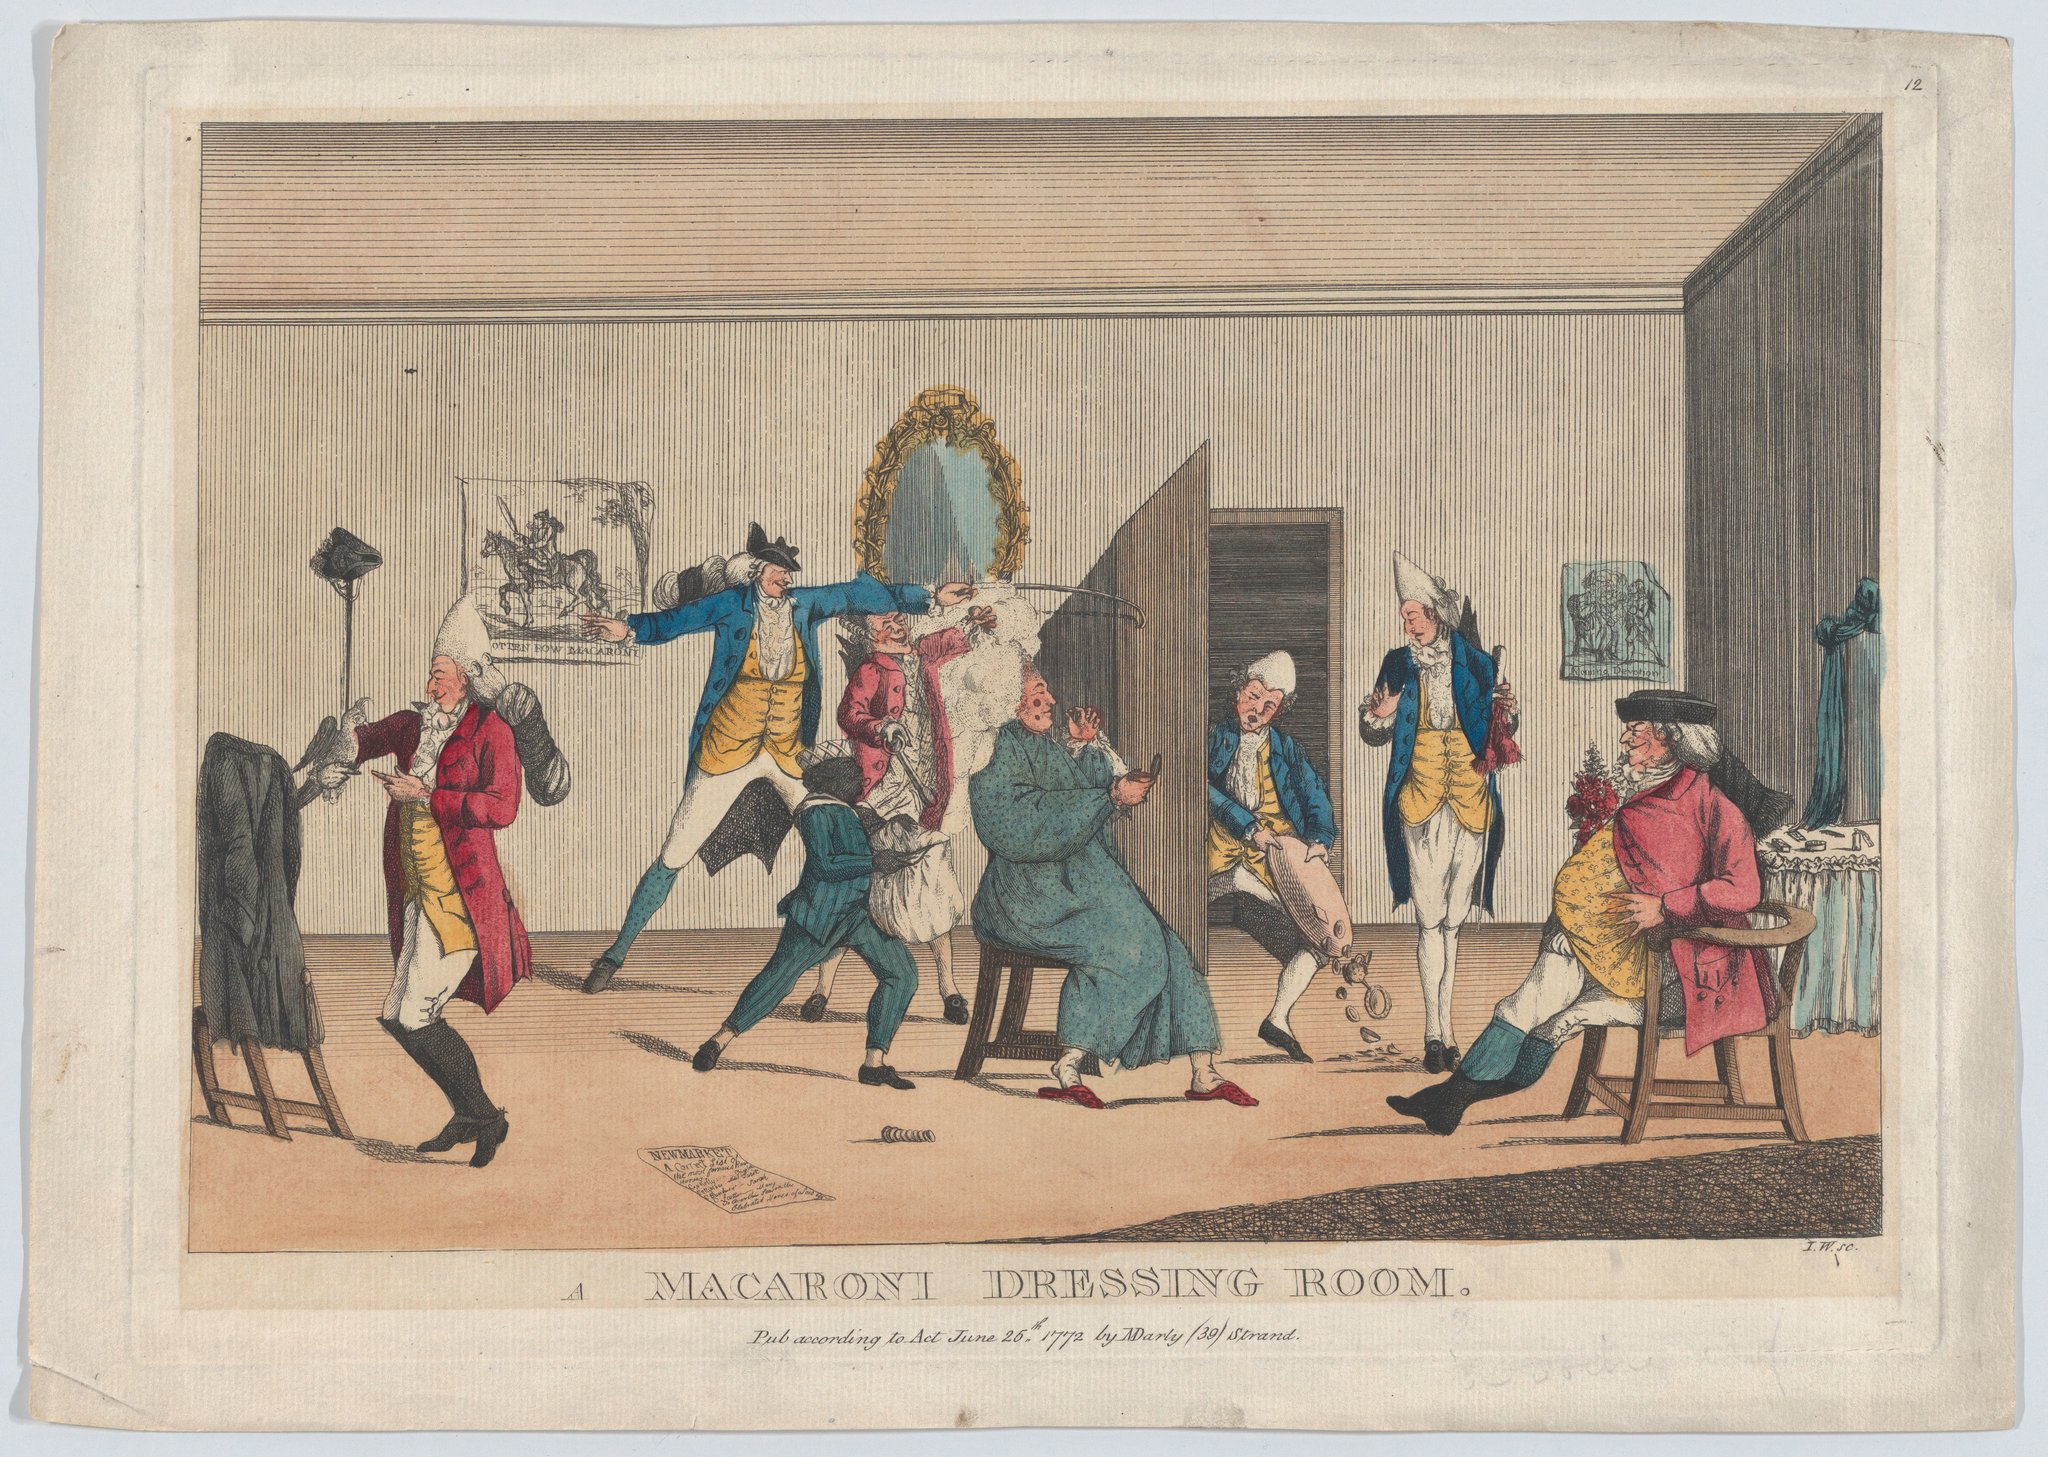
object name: print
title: A Macaroni Dressing Room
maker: i.w.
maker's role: etcher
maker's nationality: british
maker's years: 1770-1775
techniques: etching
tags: satire,men,dressing,wigs